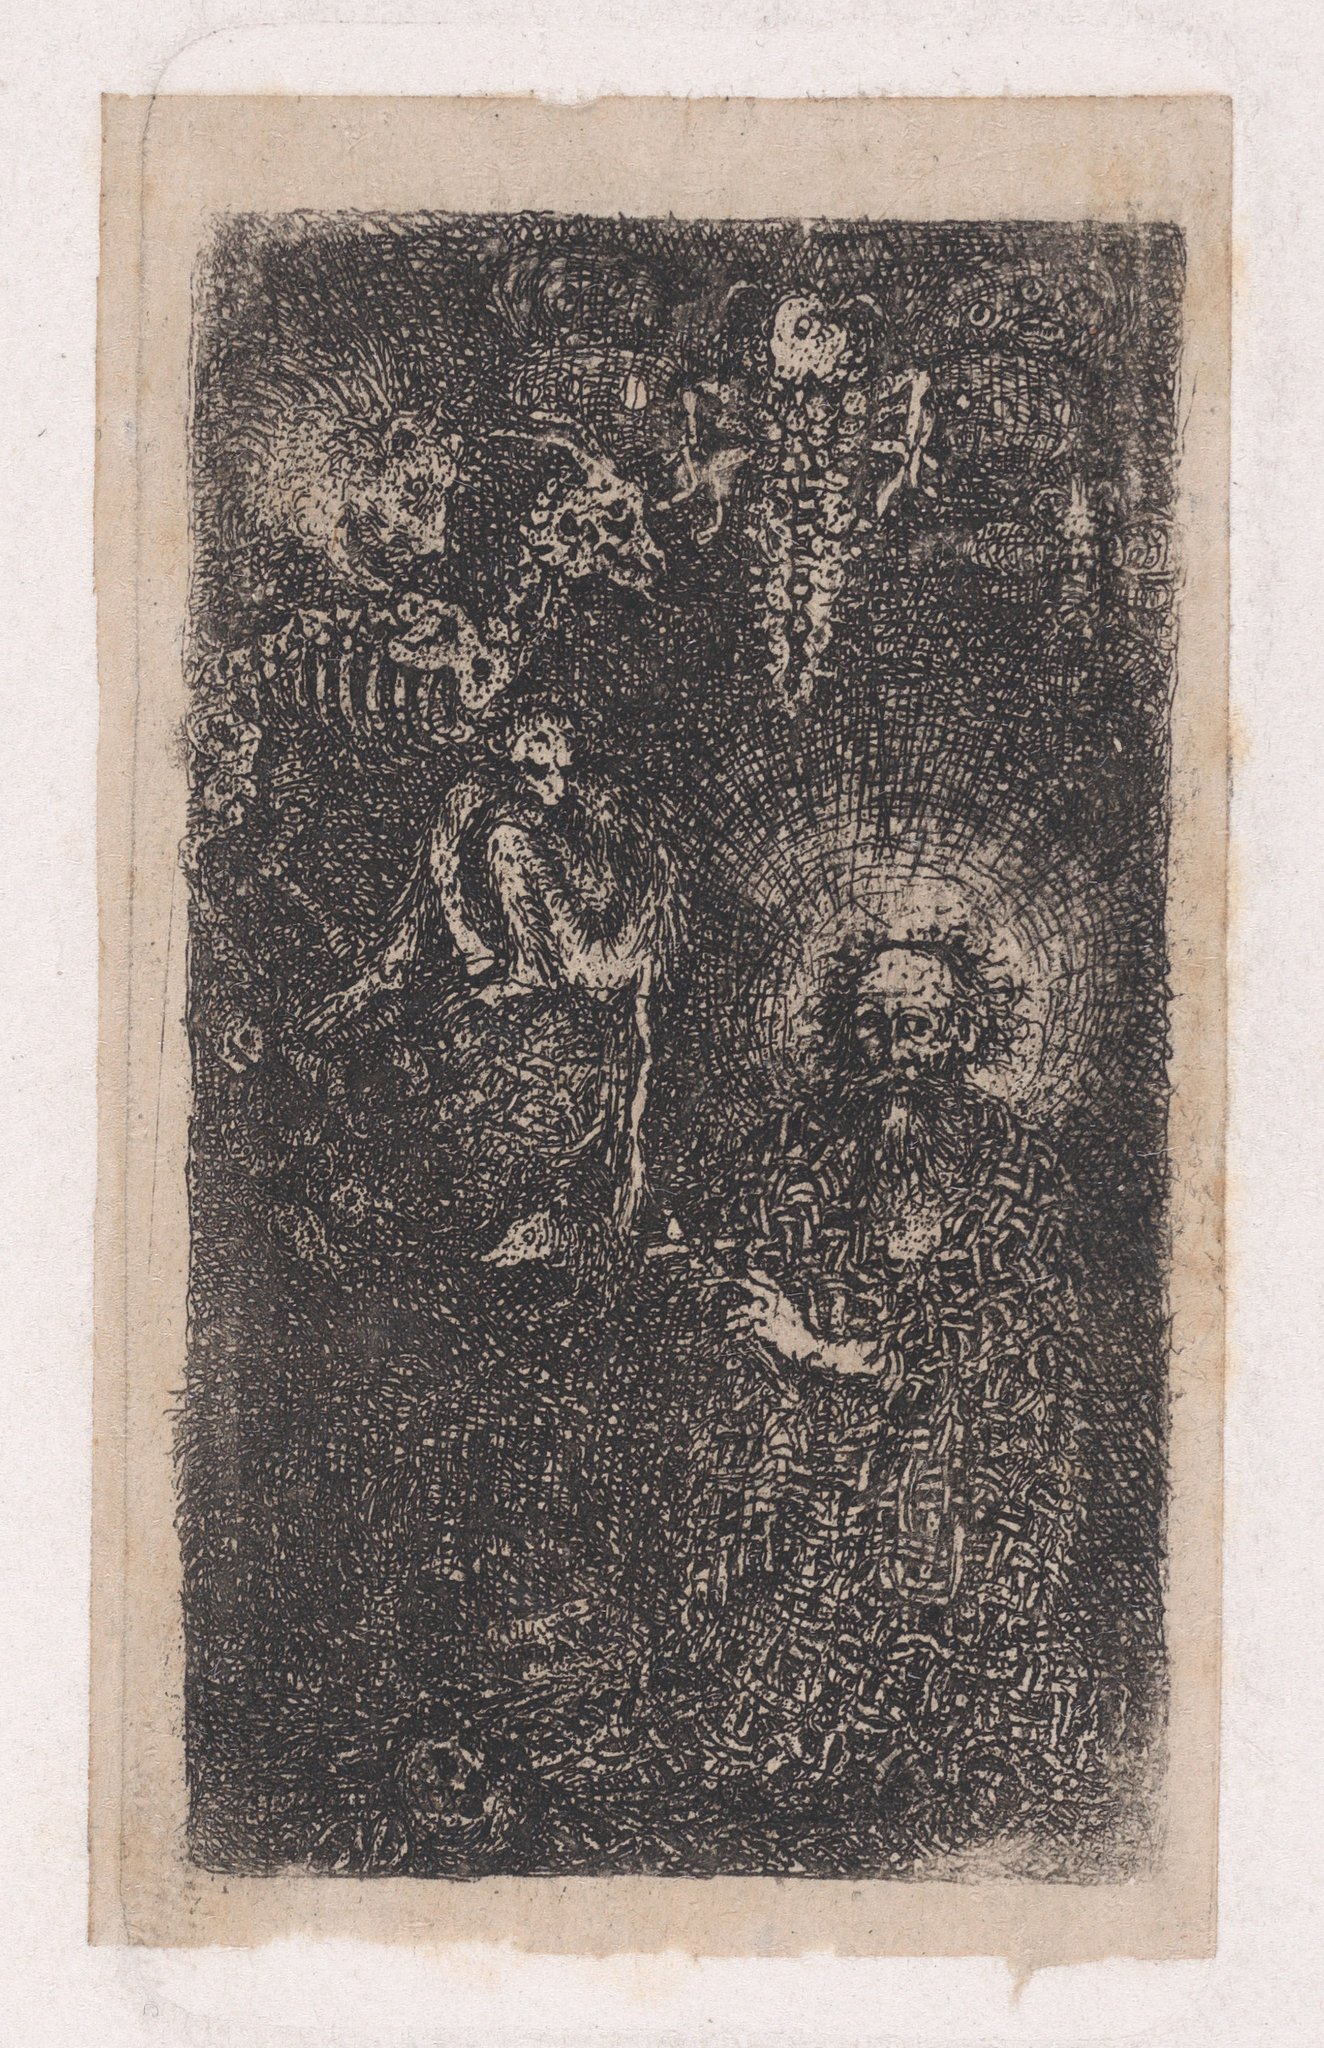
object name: print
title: La Tentation de Saint Antoine (The Temptation of St. Anthony)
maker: rodolphe bresdin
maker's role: artist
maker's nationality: french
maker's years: 1822-1885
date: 1801-1900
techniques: etching